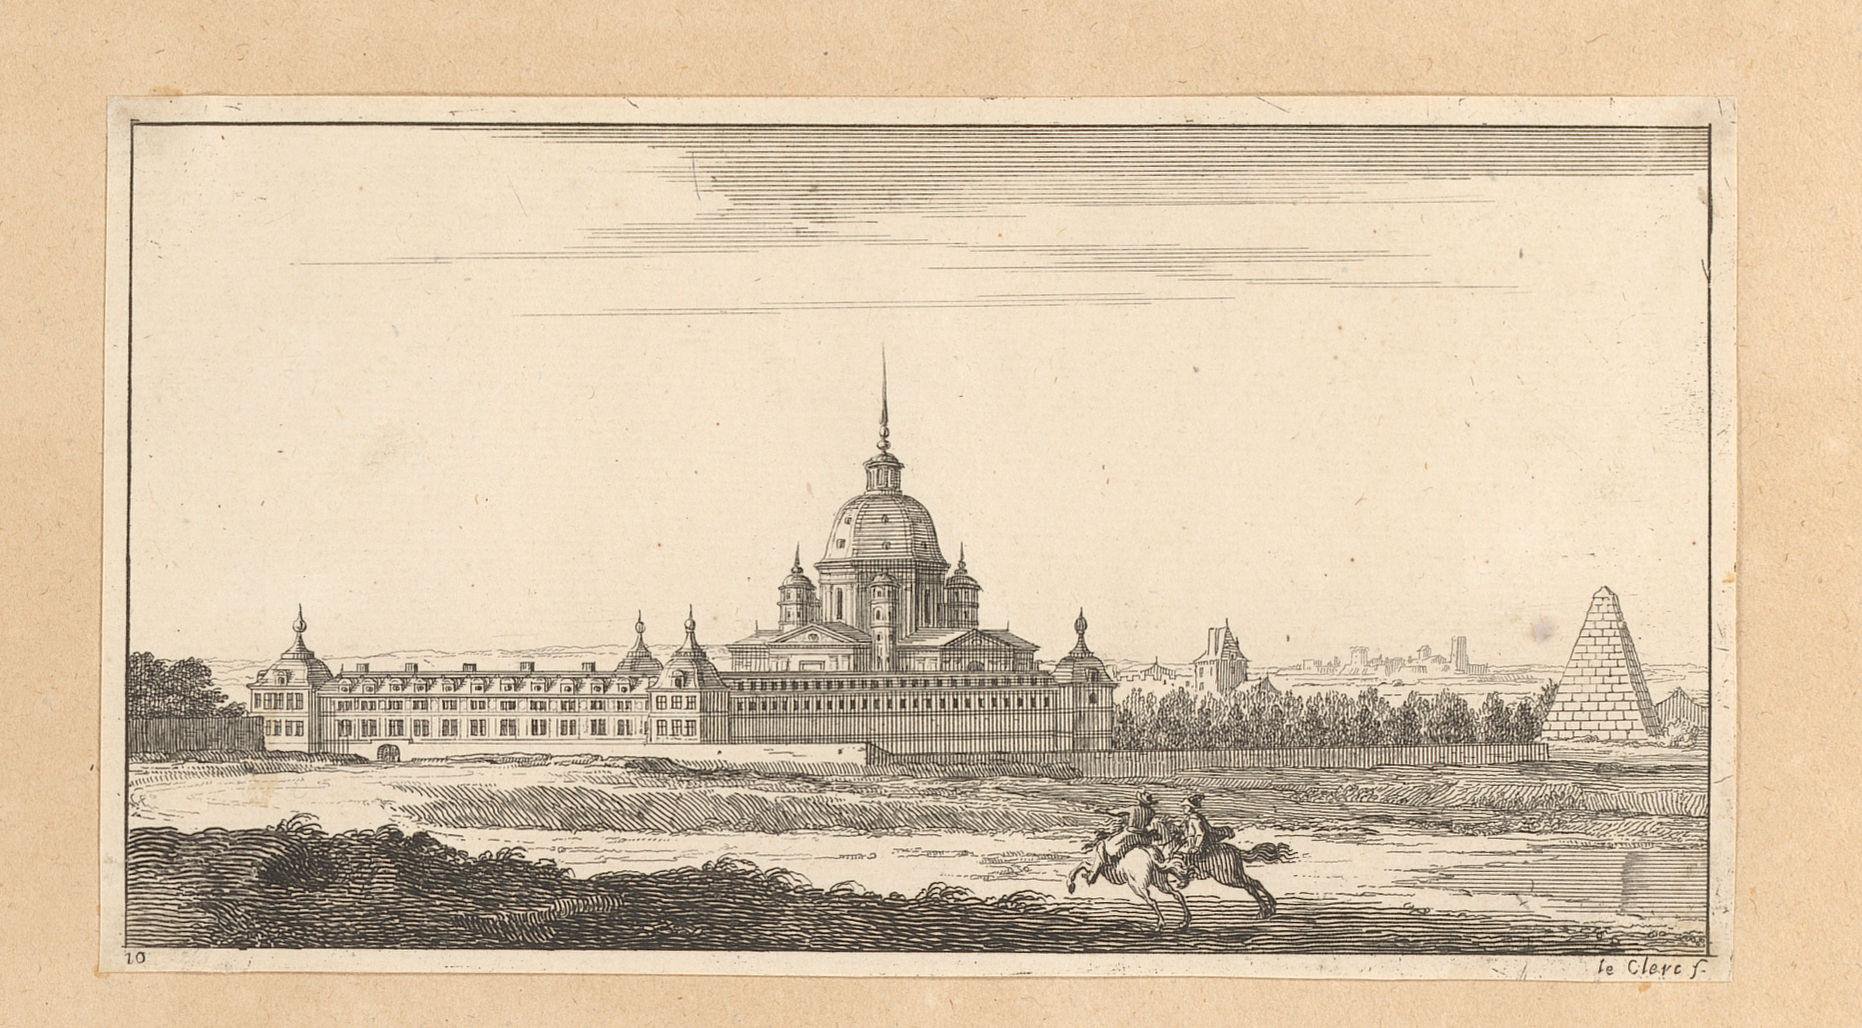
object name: album leaf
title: Gezicht op een klooster in een landschap met op de voorgrond twee ruiters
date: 1693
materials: paper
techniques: etching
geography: paris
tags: city-view, and landscape with man-made constructions, cloisters ~ monastery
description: Maakt deel uit van een twaalfdelige serie met landschappen en gezichten op verschillende gebouwen. Een eerste editie werd uitgegeven door Nicolas Langlois in 1693 en een tweede in 1784 door Lamy.